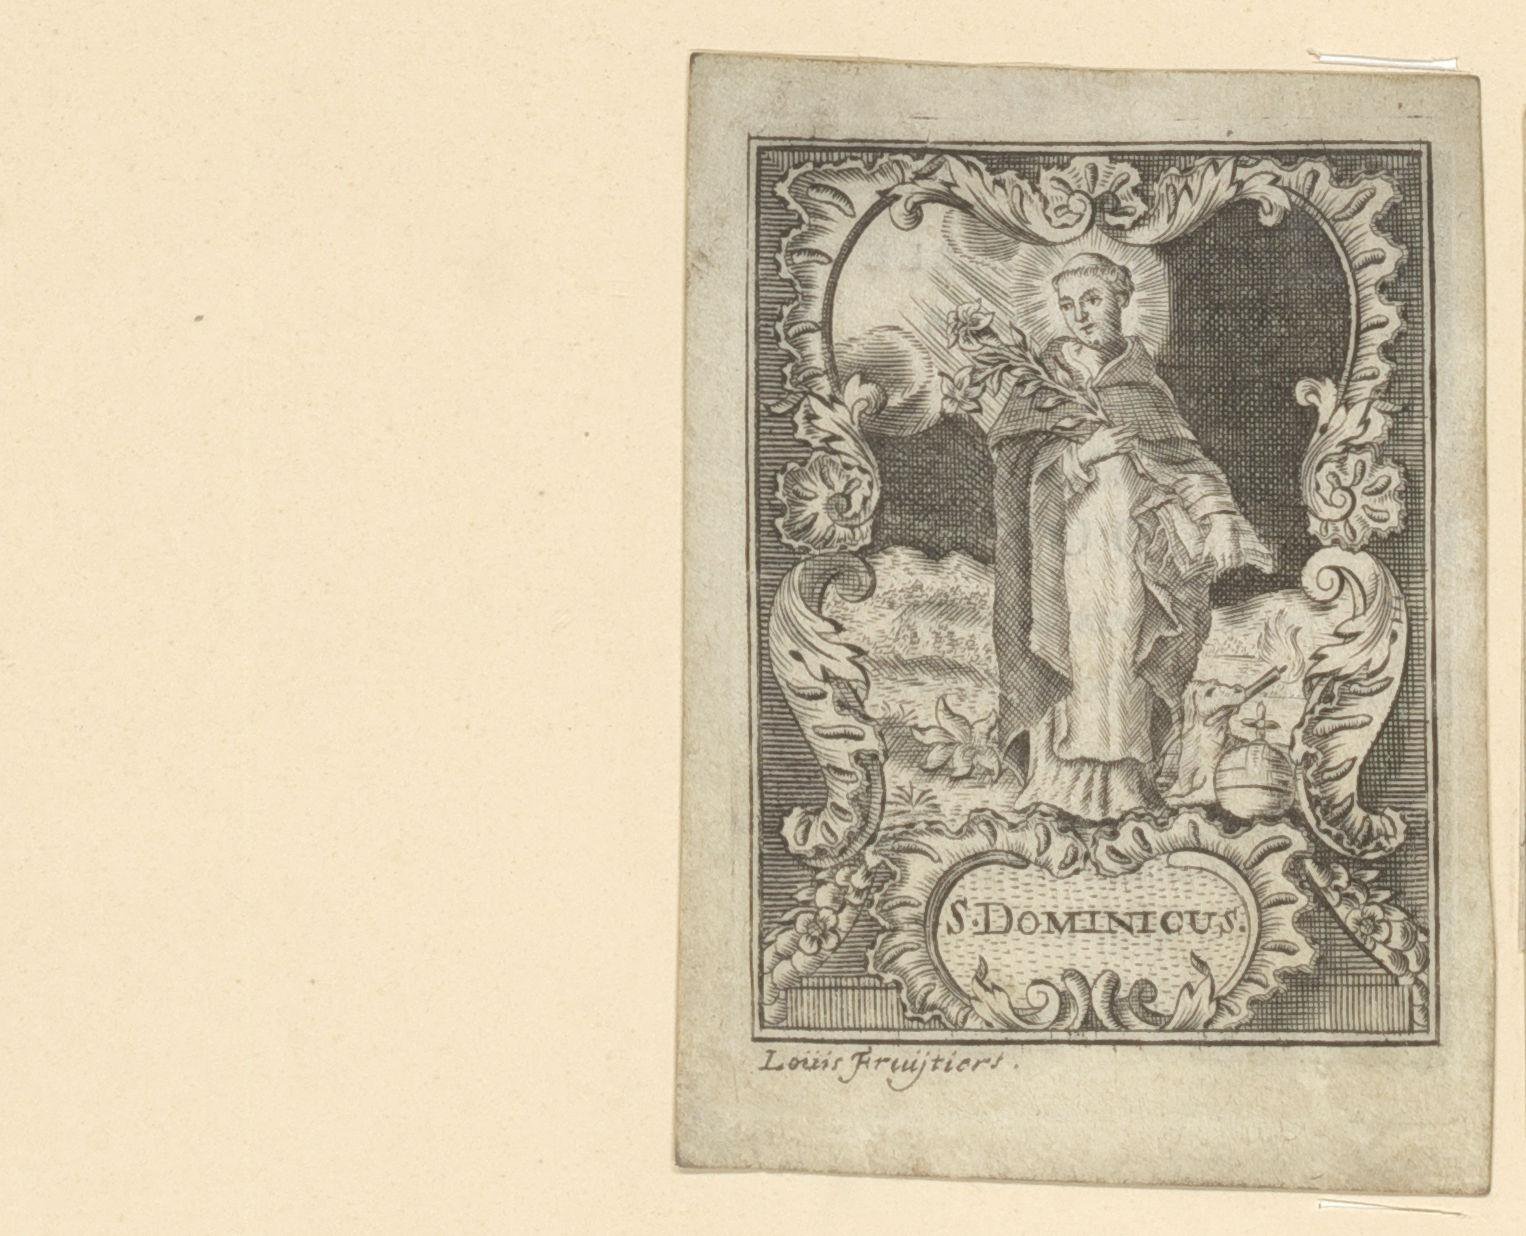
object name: print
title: S. Dominicus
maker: lodewijk joseph fruytiers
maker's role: print maker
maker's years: 1713-1782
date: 1723-1782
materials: paper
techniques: engraving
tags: dominic(us) guzman of calerueja, founder of the order of preachers (or dominican (black) friars; possible attributes: book, dog with flaming torch, lily, loaf of bread, rosary, star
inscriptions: collector's mark: Lugt 1641, stamp, stamp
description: Bidprent voor Gertrudis Maria Cloots, overleden op 16 maart 1789. Onderwerpsrubrieken binnen de Atlas Zeden en Gewoonten: Godsdienst, Roomsch-Katholieken, Processies, Herinneringen.